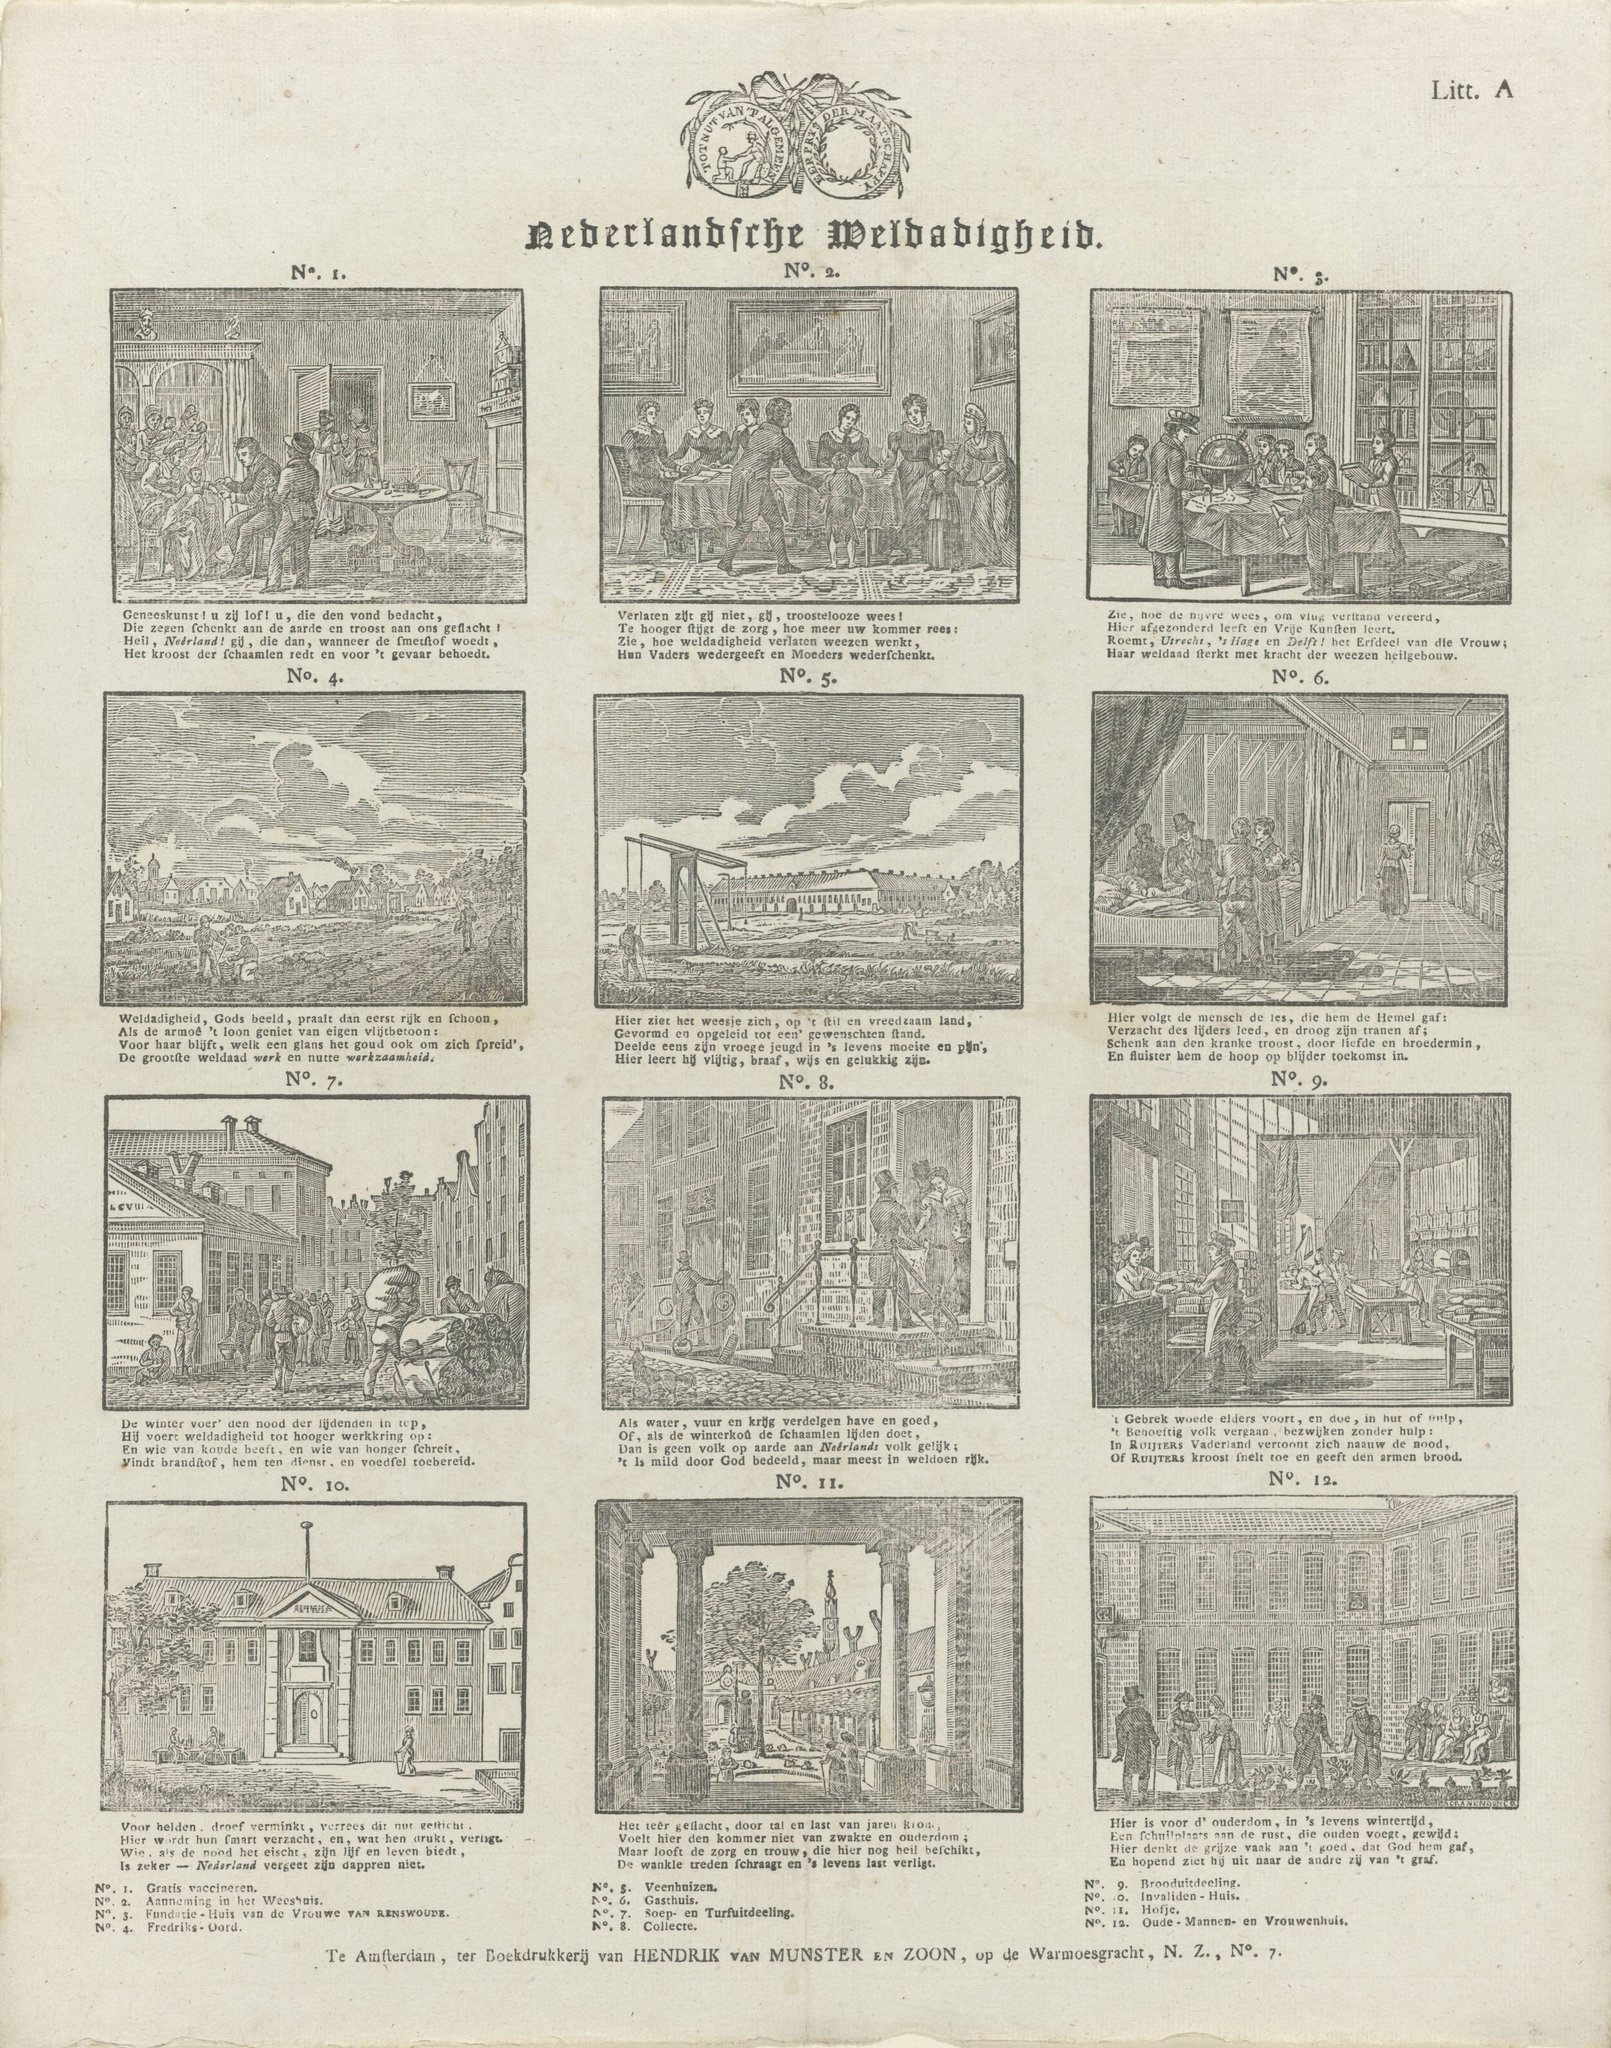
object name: print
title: Nederlandsche weldadigheid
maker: alexander cranendoncq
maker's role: draughtsman, print maker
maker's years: 1799-1869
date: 1818-1829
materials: paper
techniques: letterpress printing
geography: netherlands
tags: foundling-hospital, vaccination, orphanage, charitable works, netherlands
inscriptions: collector's mark: Lugt 2228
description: Blad met 12 voorstellingen over weldadigheid in Nederland, waaronder weergaven van gratis vaccineren, gasthuizen en brooduitdeling. Boven elke afbeelding een nummer en onder elke afbeelding een vierregelig vers. Onder aan het blad een legenda met de titels bij de prenten. Midden boven het zegel van de Maatschappij tot Nut van 't Algemeen. Gemerkt rechtsboven: Litt. A.